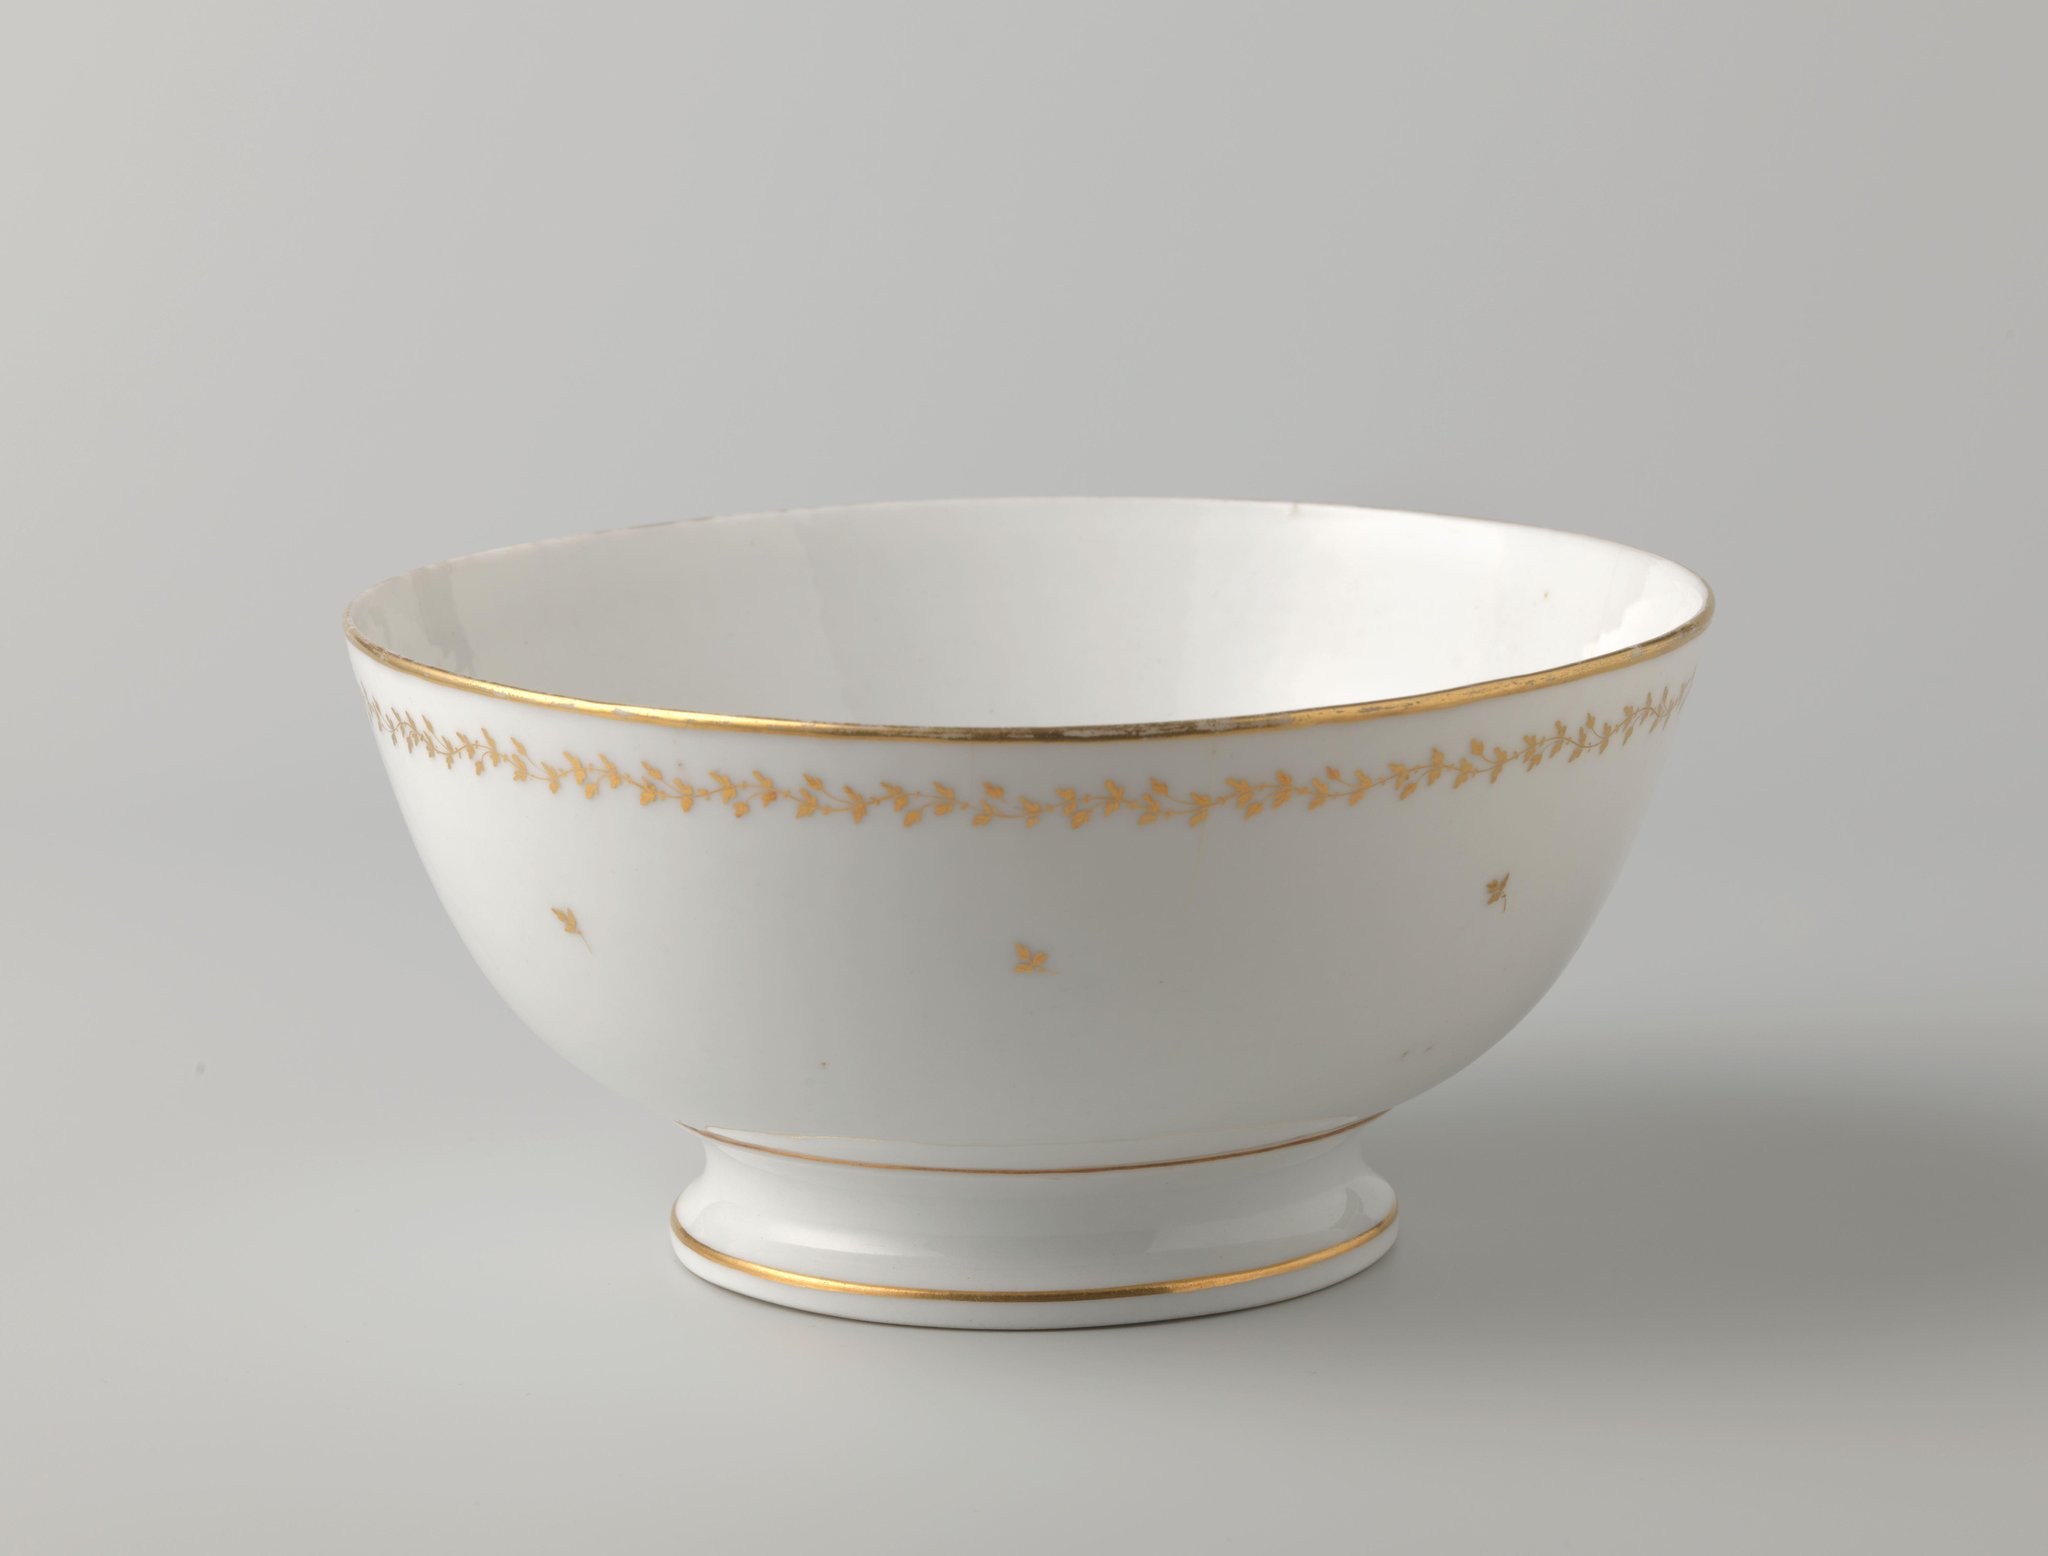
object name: slop bowl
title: Spoelkom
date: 1809-1814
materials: porcelain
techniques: painted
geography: nieuwer-amstel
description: Spoelkom versierd met gouden biezen, strooiblaadjes en een golvende twijg rond de hals of rand.